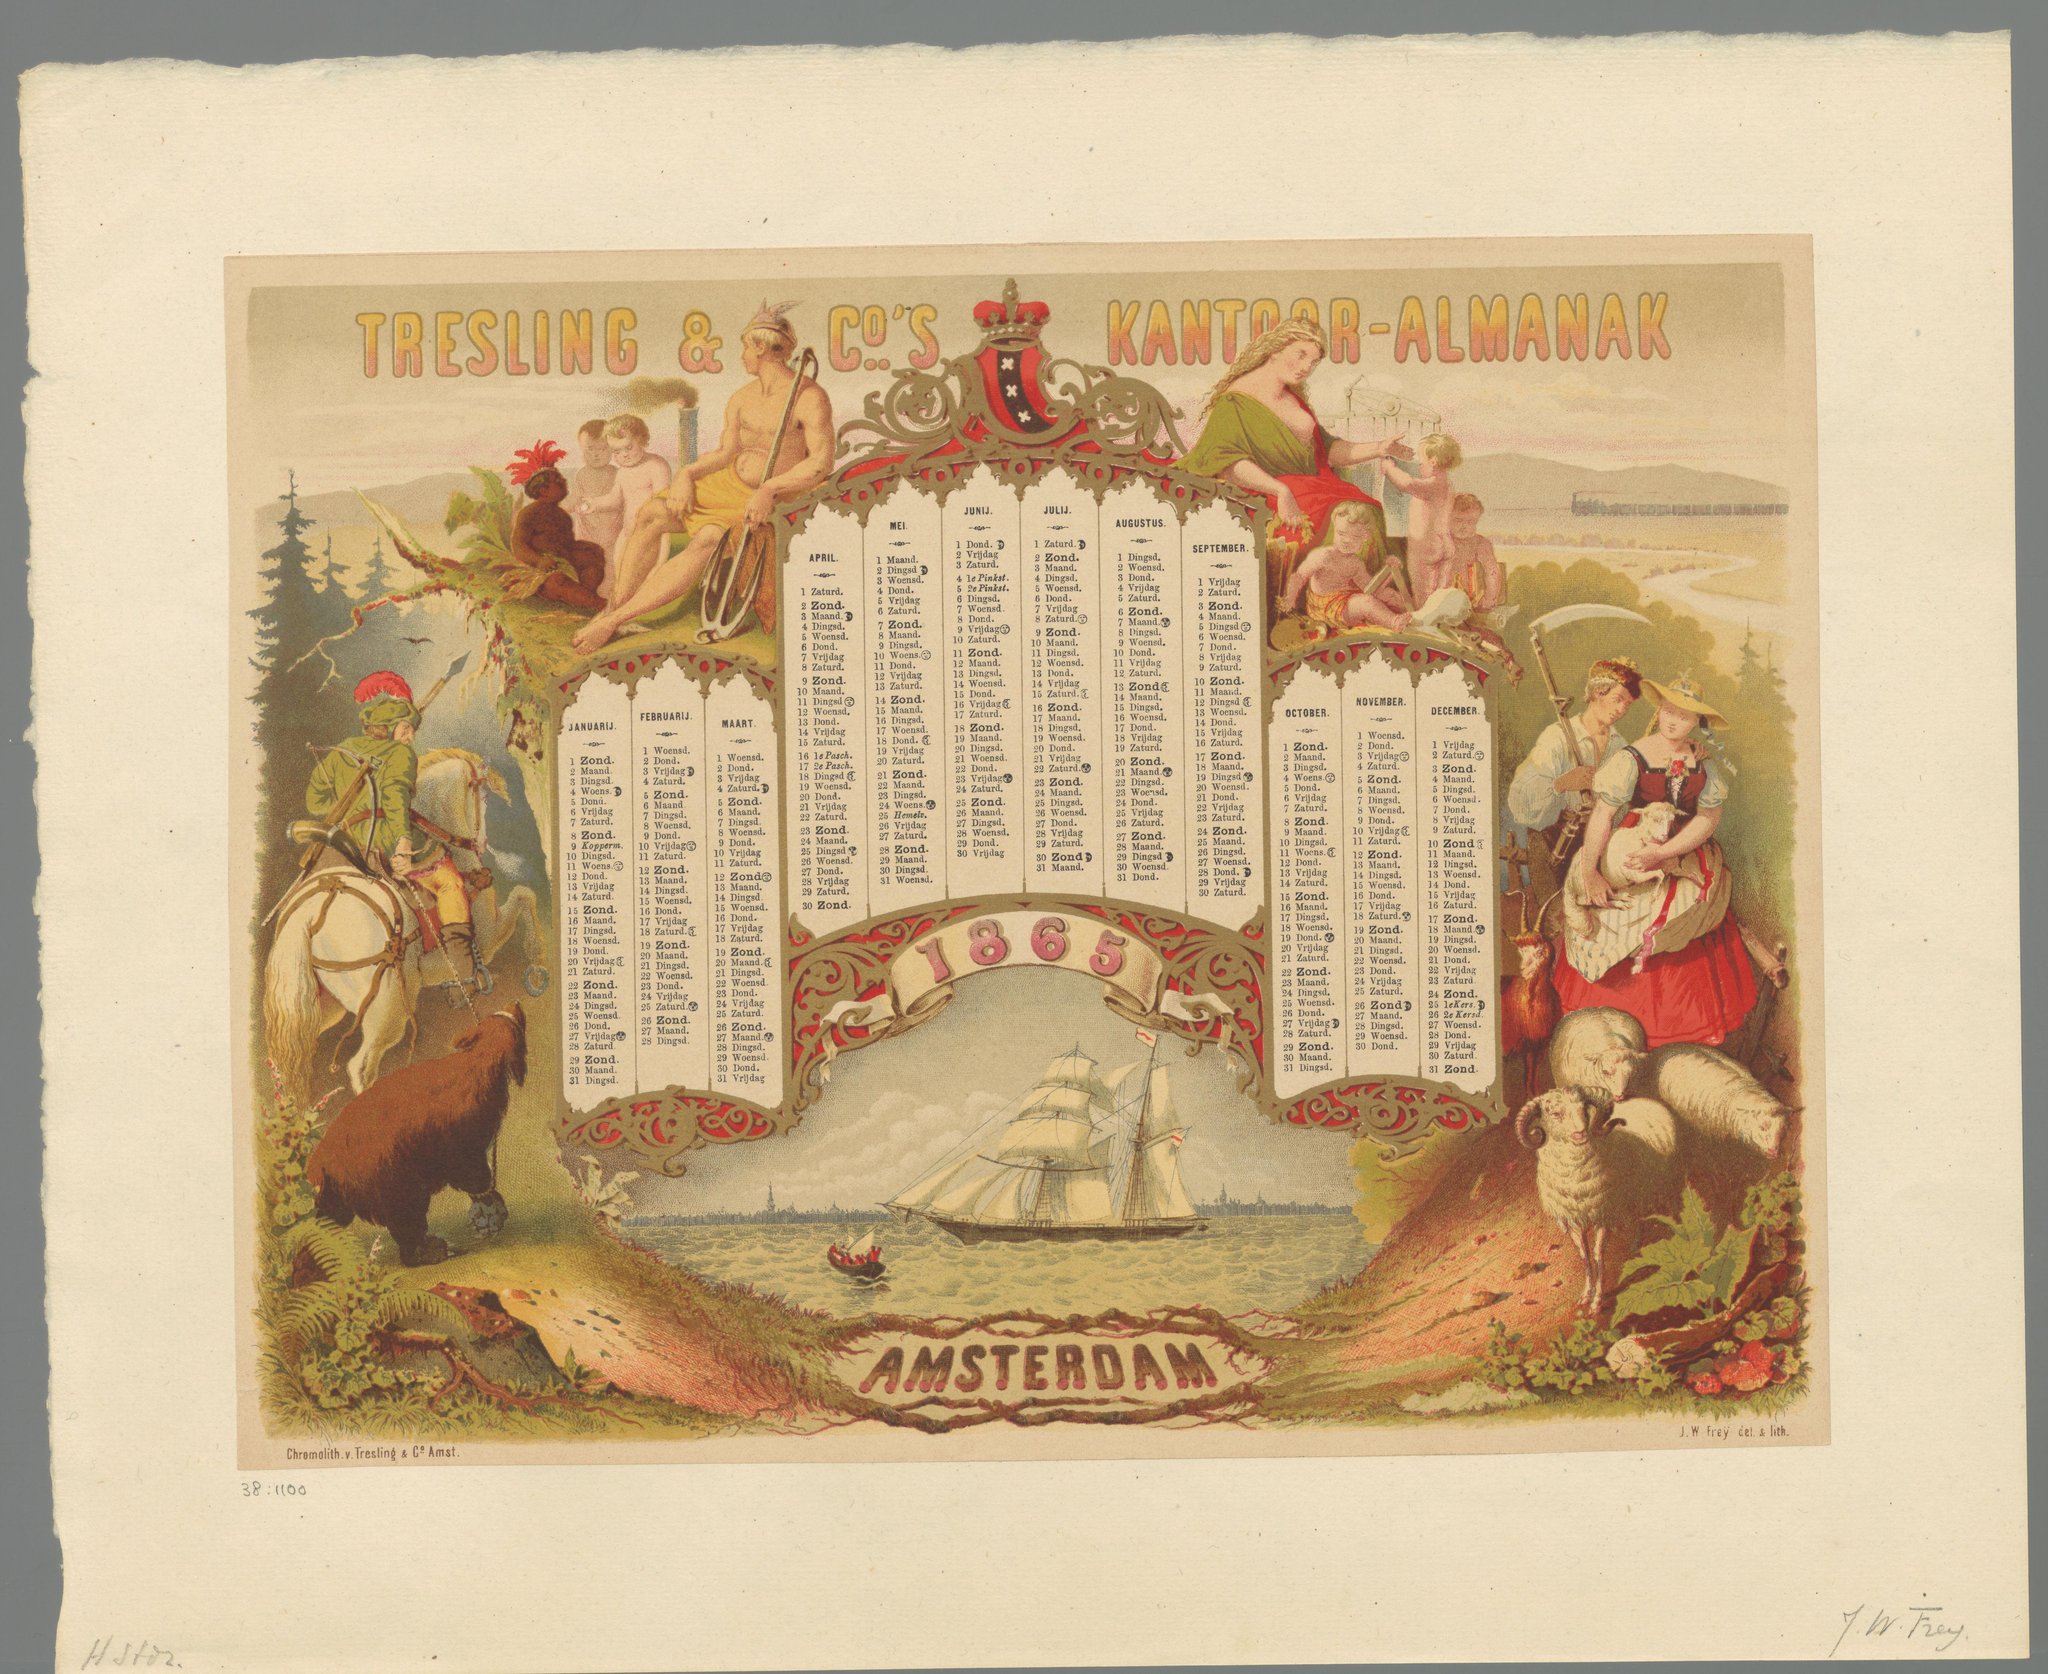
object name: calendar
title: Treslings & co's kantoor-almanak Amsterdam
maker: johann wilhelm frey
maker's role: print maker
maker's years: 1830-1890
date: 1865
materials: paper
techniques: lithograph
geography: amsterdam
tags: calendar, almanac, sailing-ship, sailing-boat, herding, herdsman, herdswoman, shepherd, shepherdess, cowherd, etc., beasts of prey, predatory animals: bear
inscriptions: collector's mark: Lugt 2760, collector's mark: Lugt 2228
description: Midden boven staat het stadswapen van Amsterdam met links Mercurius, god van de handel, en rechts een personificatie van de Kunsten. Midden onder een gezicht op een zeilschip met links een jager met gevangen beer en rechts herders met schapen.